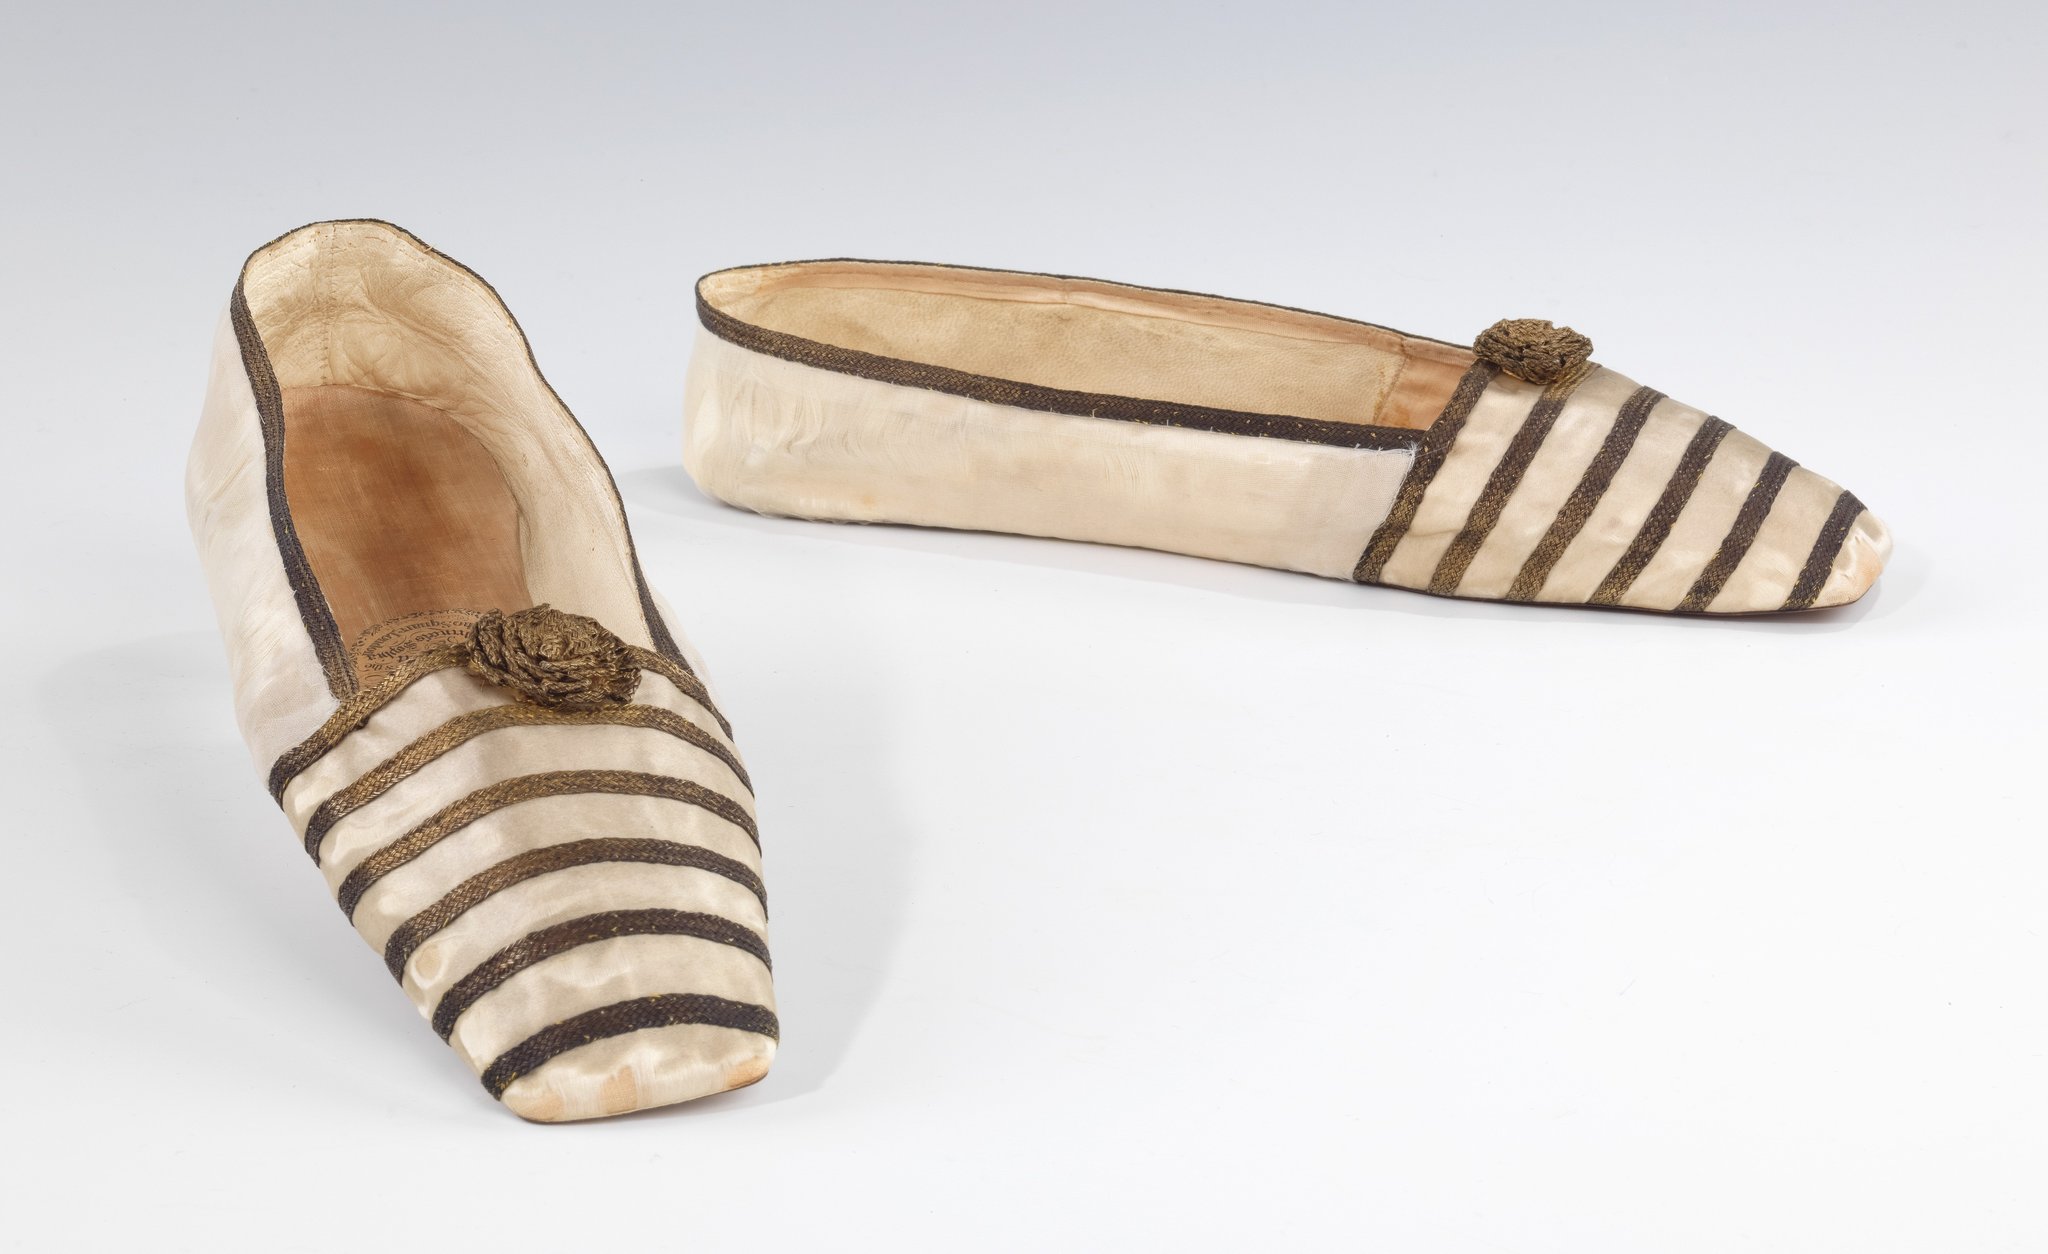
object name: evening slipper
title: Evening slippers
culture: british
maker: gundry & sons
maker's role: designer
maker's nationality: british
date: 1840-1849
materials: metal, silk